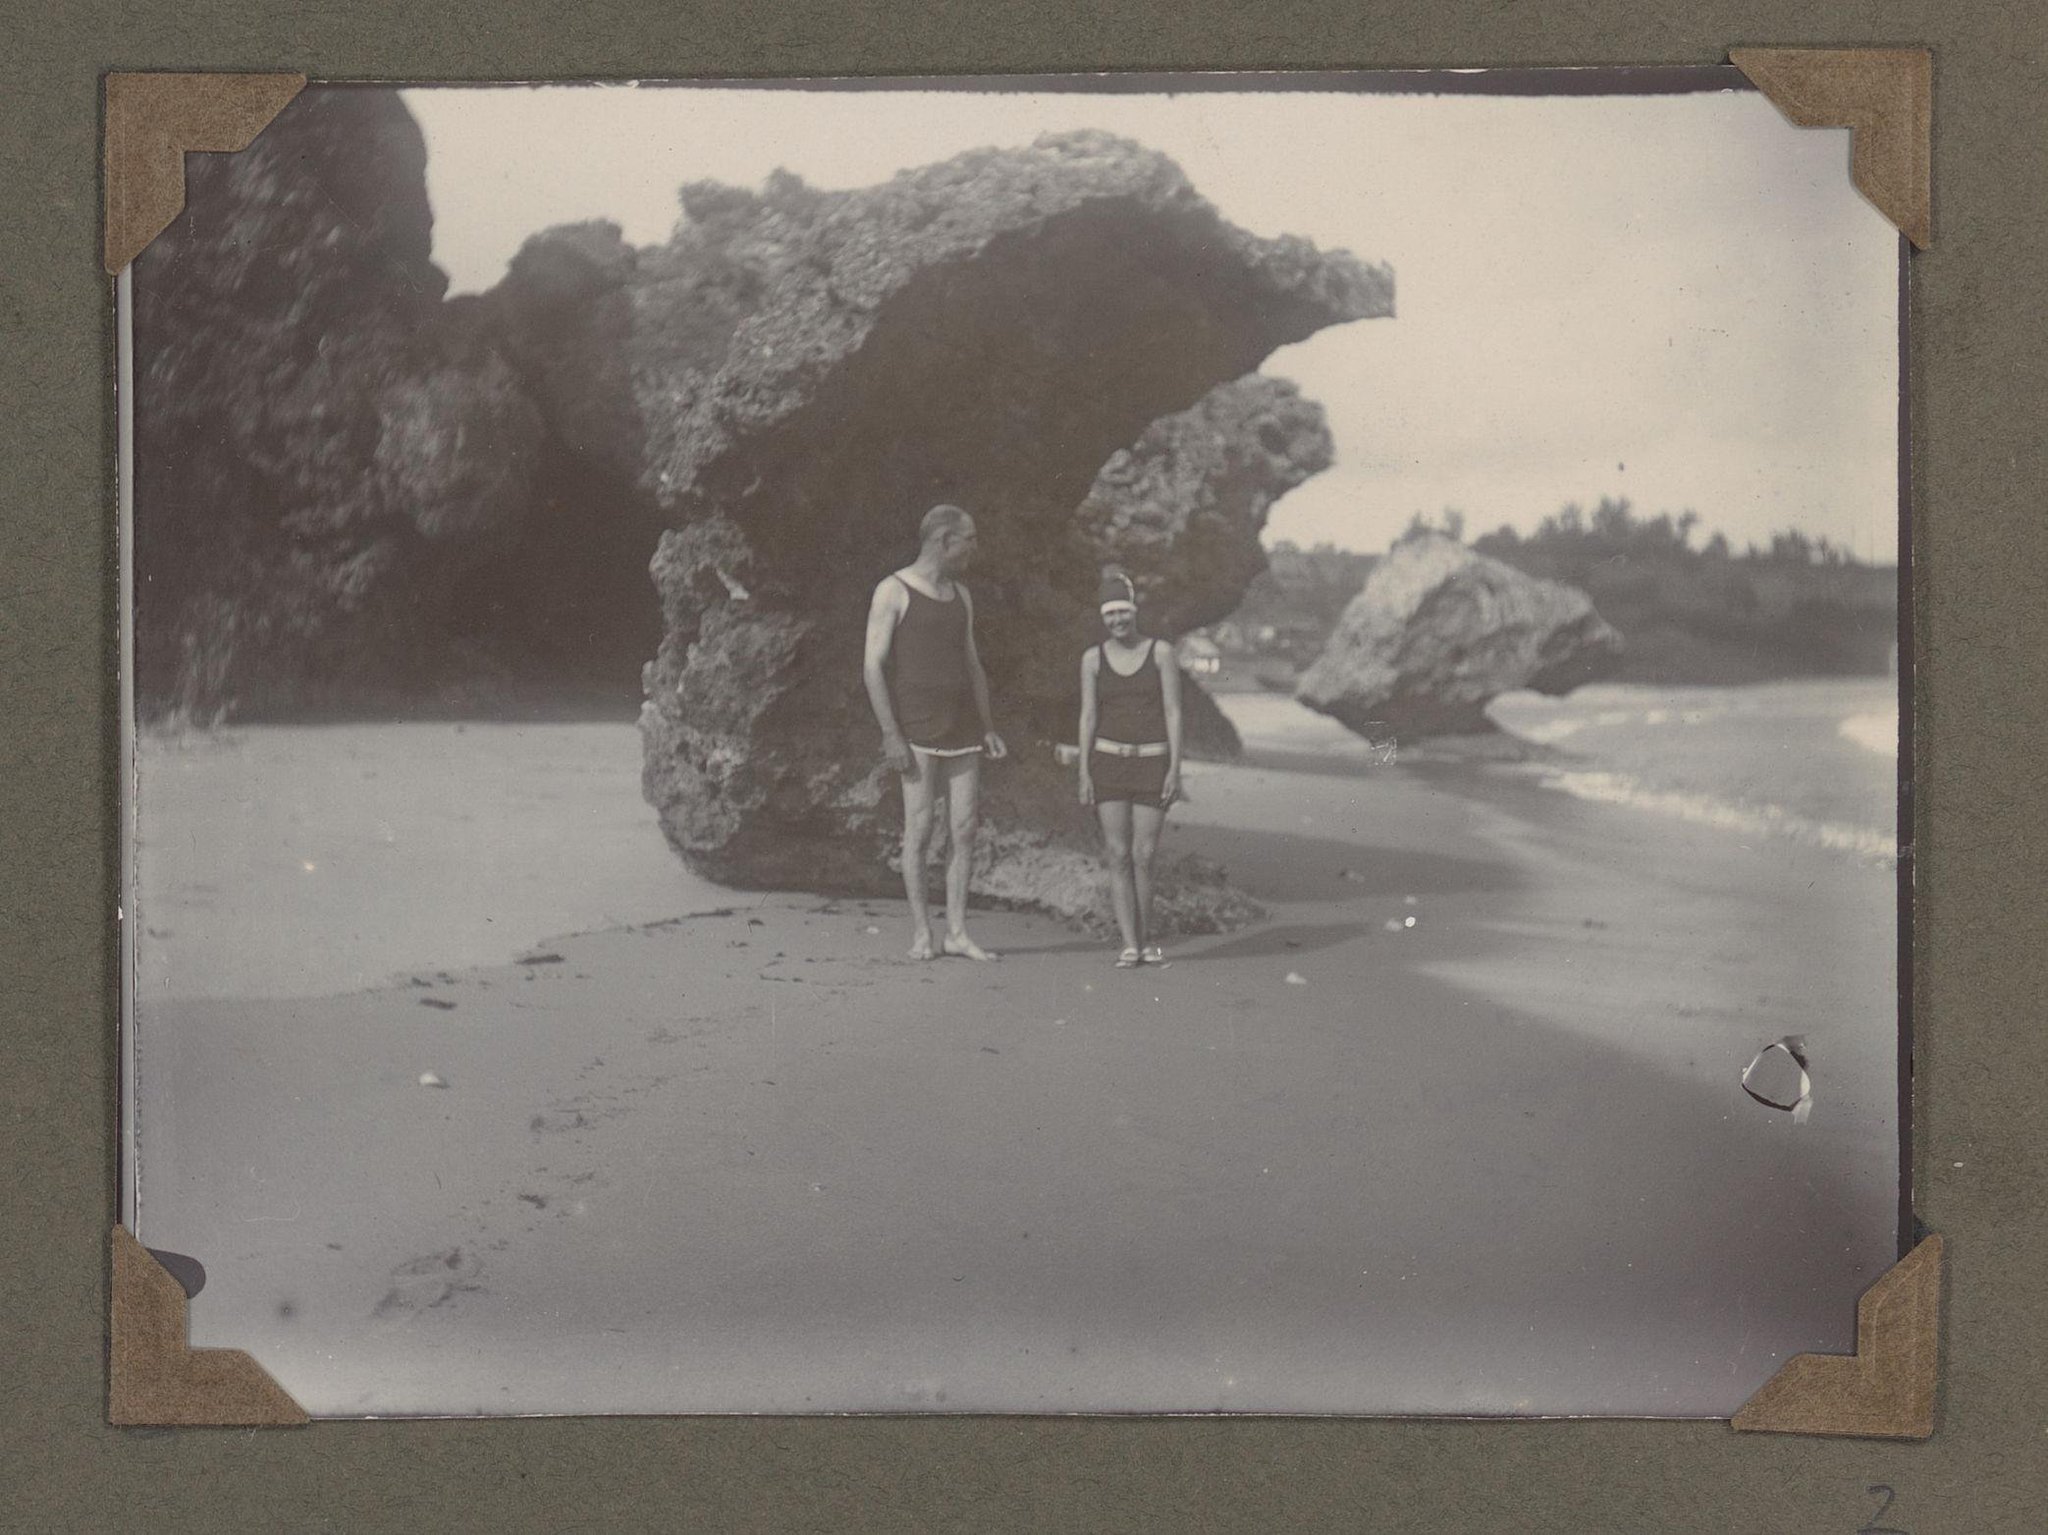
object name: photograph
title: Familiefoto van de vakantie op Barbados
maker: Anonymous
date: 1925-1927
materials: photographic support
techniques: photography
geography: suriname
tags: jetten, familie, moengo, barbados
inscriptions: inscription: ‘Barbedos’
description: Familiefoto van het gezin Jetten op vakantie in Barbados. Foto op een bladzijde van een los albumblad. Onderdeel van het ensemble met foto's van de familie van ingenieur Jetten in de mijnbouwstad Moengo in Suriname.